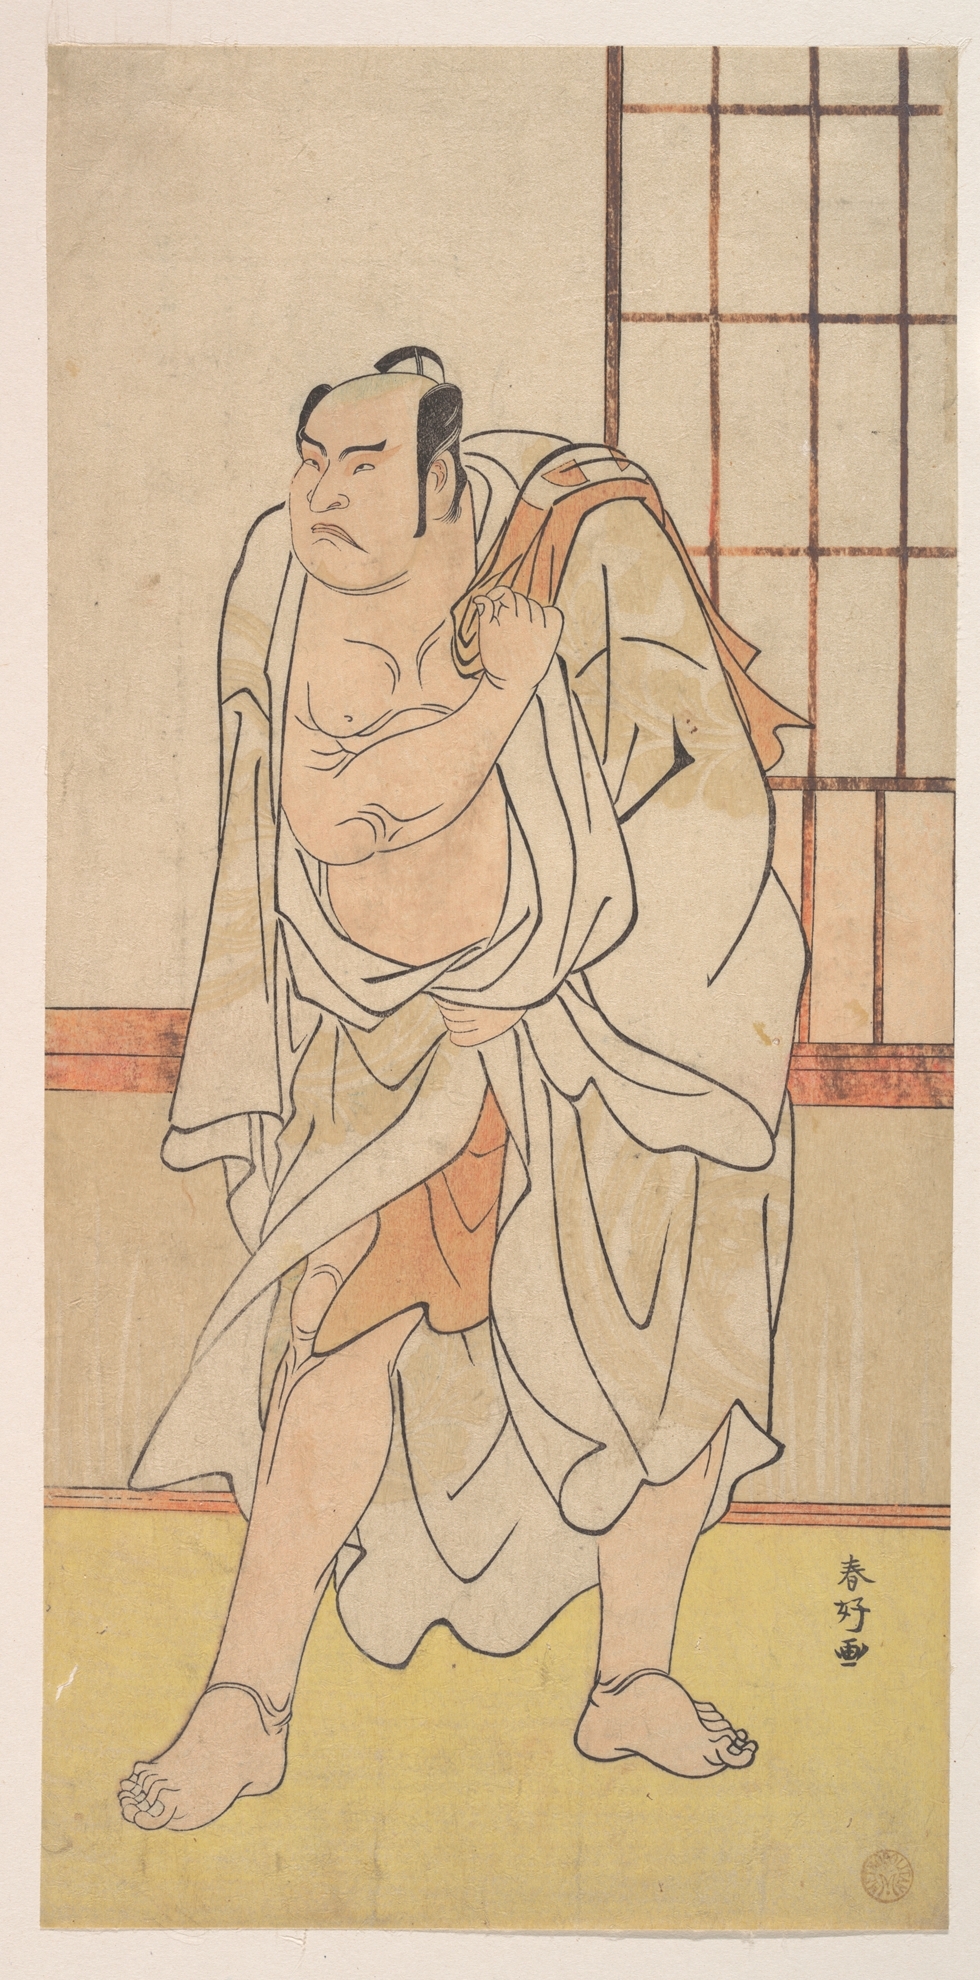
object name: print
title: The Third Otani Hiroji as a Wrestler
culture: japanese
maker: katsukawa shunkō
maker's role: artist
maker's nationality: japanese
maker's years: 1743-1812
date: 1790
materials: ink, paper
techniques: woodblock print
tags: men,actors